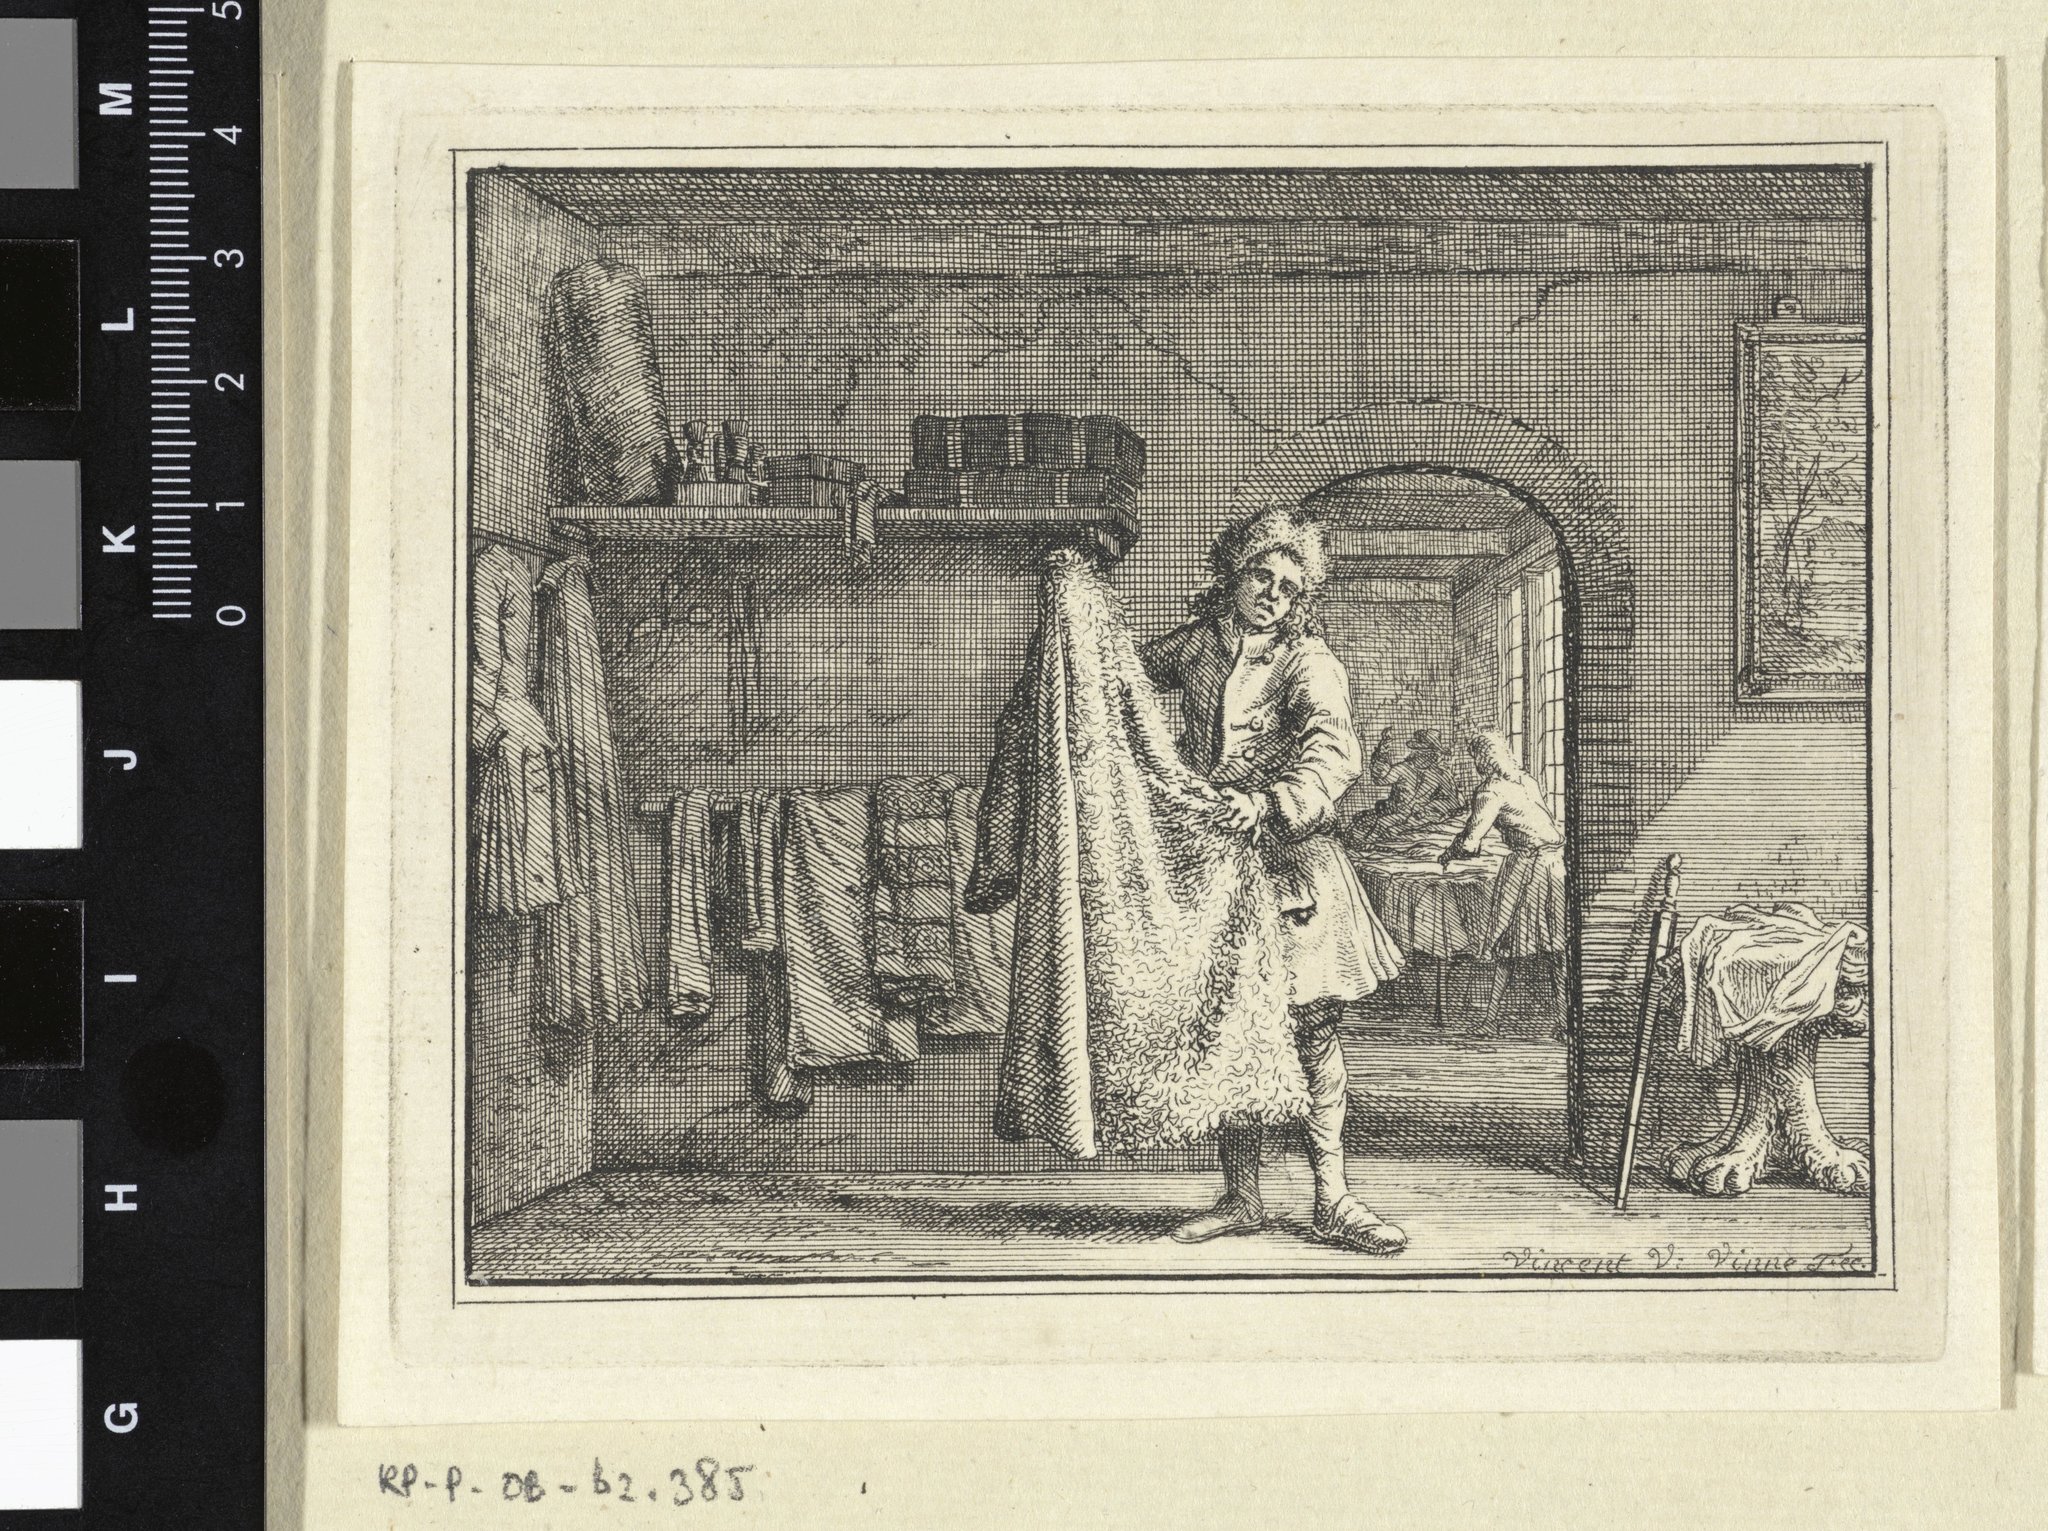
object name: print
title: Kleermaker met bontmantel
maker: vincent laurensz. van der vinne (ii)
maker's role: draughtsman, print maker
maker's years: 1686-1742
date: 1714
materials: paper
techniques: etching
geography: haarlem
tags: furrier (+ variant), coat (+ men's clothes), tailor, dressmaker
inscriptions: collector's mark: Lugt 240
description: Prent oorspronkelijk bedoeld als boekillustratie voor: Spinniker, Adriaan. Leerzaame zinnebeelden. Haarlem: [boekverkoper] Isaak van der Vinne (I) en Amsterdam: [drukker] Johannes Krelius, 1714. Later gebruikt als boekillustratie in: Spinniker, Adriaan. Vervolg der leerzaame zinnebeelden, : spiegel der boetvaardigheid en genade en eenige Stichtelyke gezangen. Haarlem: Jan Bosch, 1758.